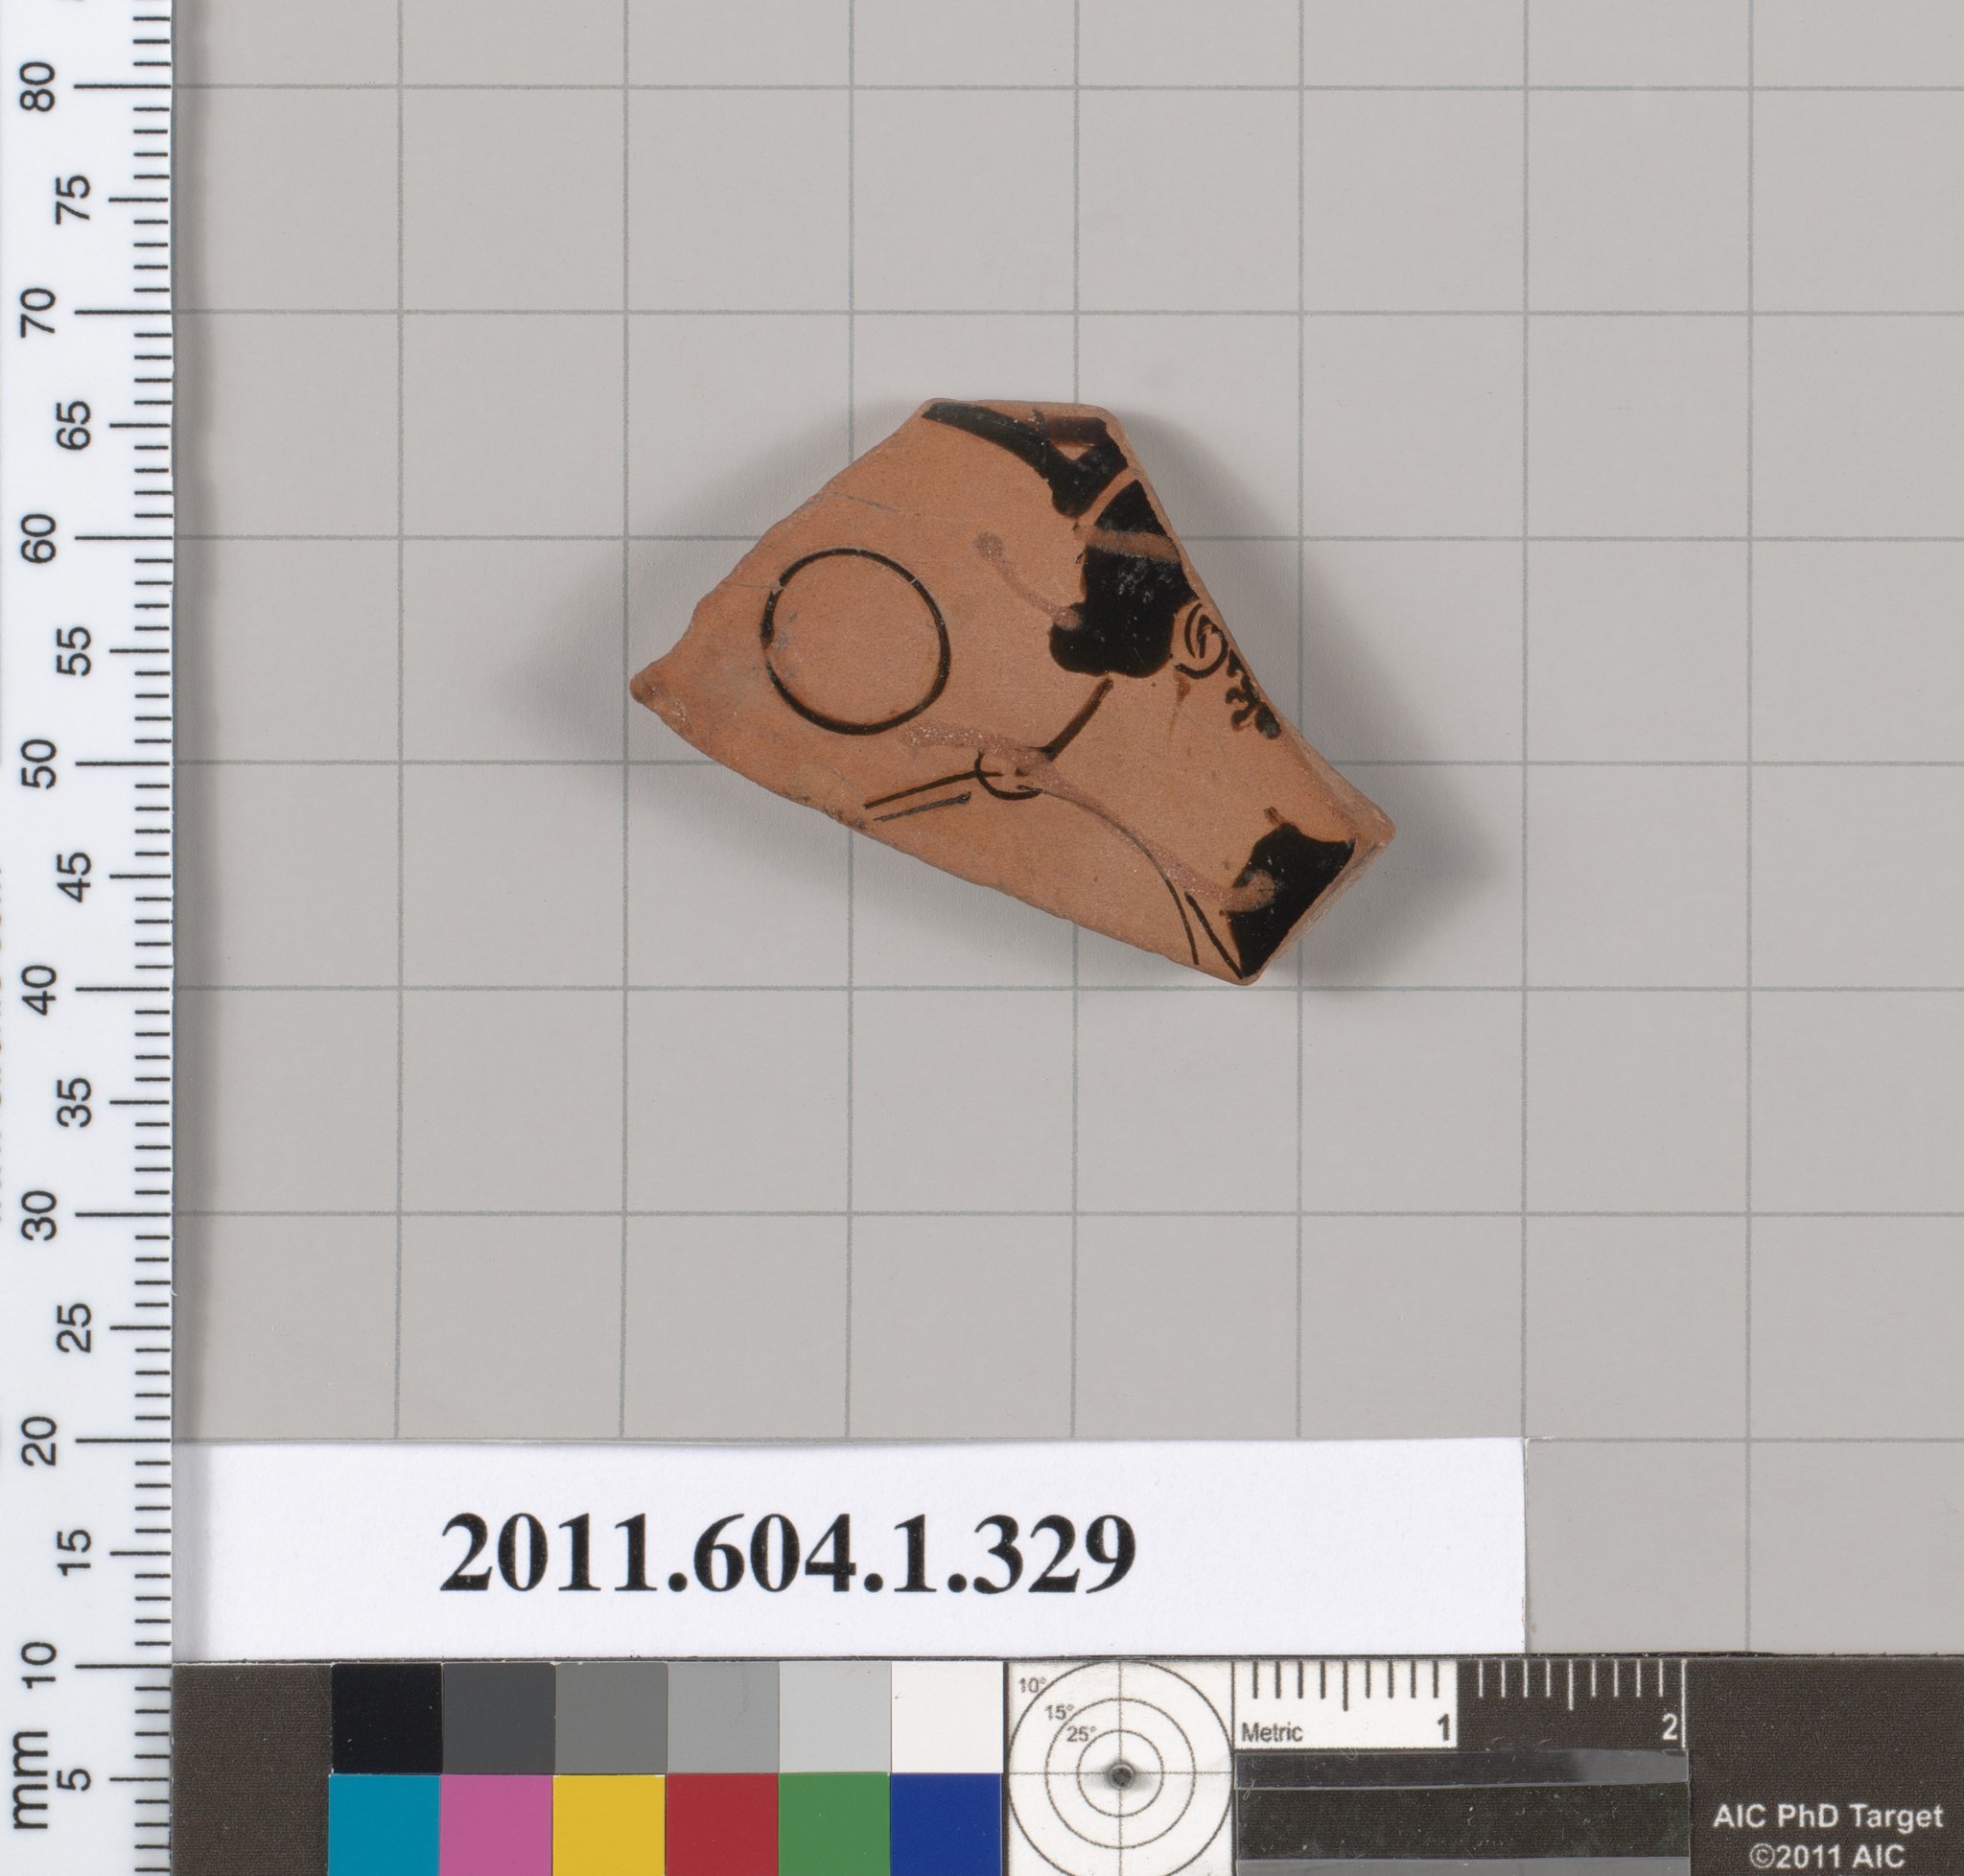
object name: kylix fragment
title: Terracotta rim fragment of a kylix (drinking cup)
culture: greek, attic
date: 475-451 BCE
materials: terracotta